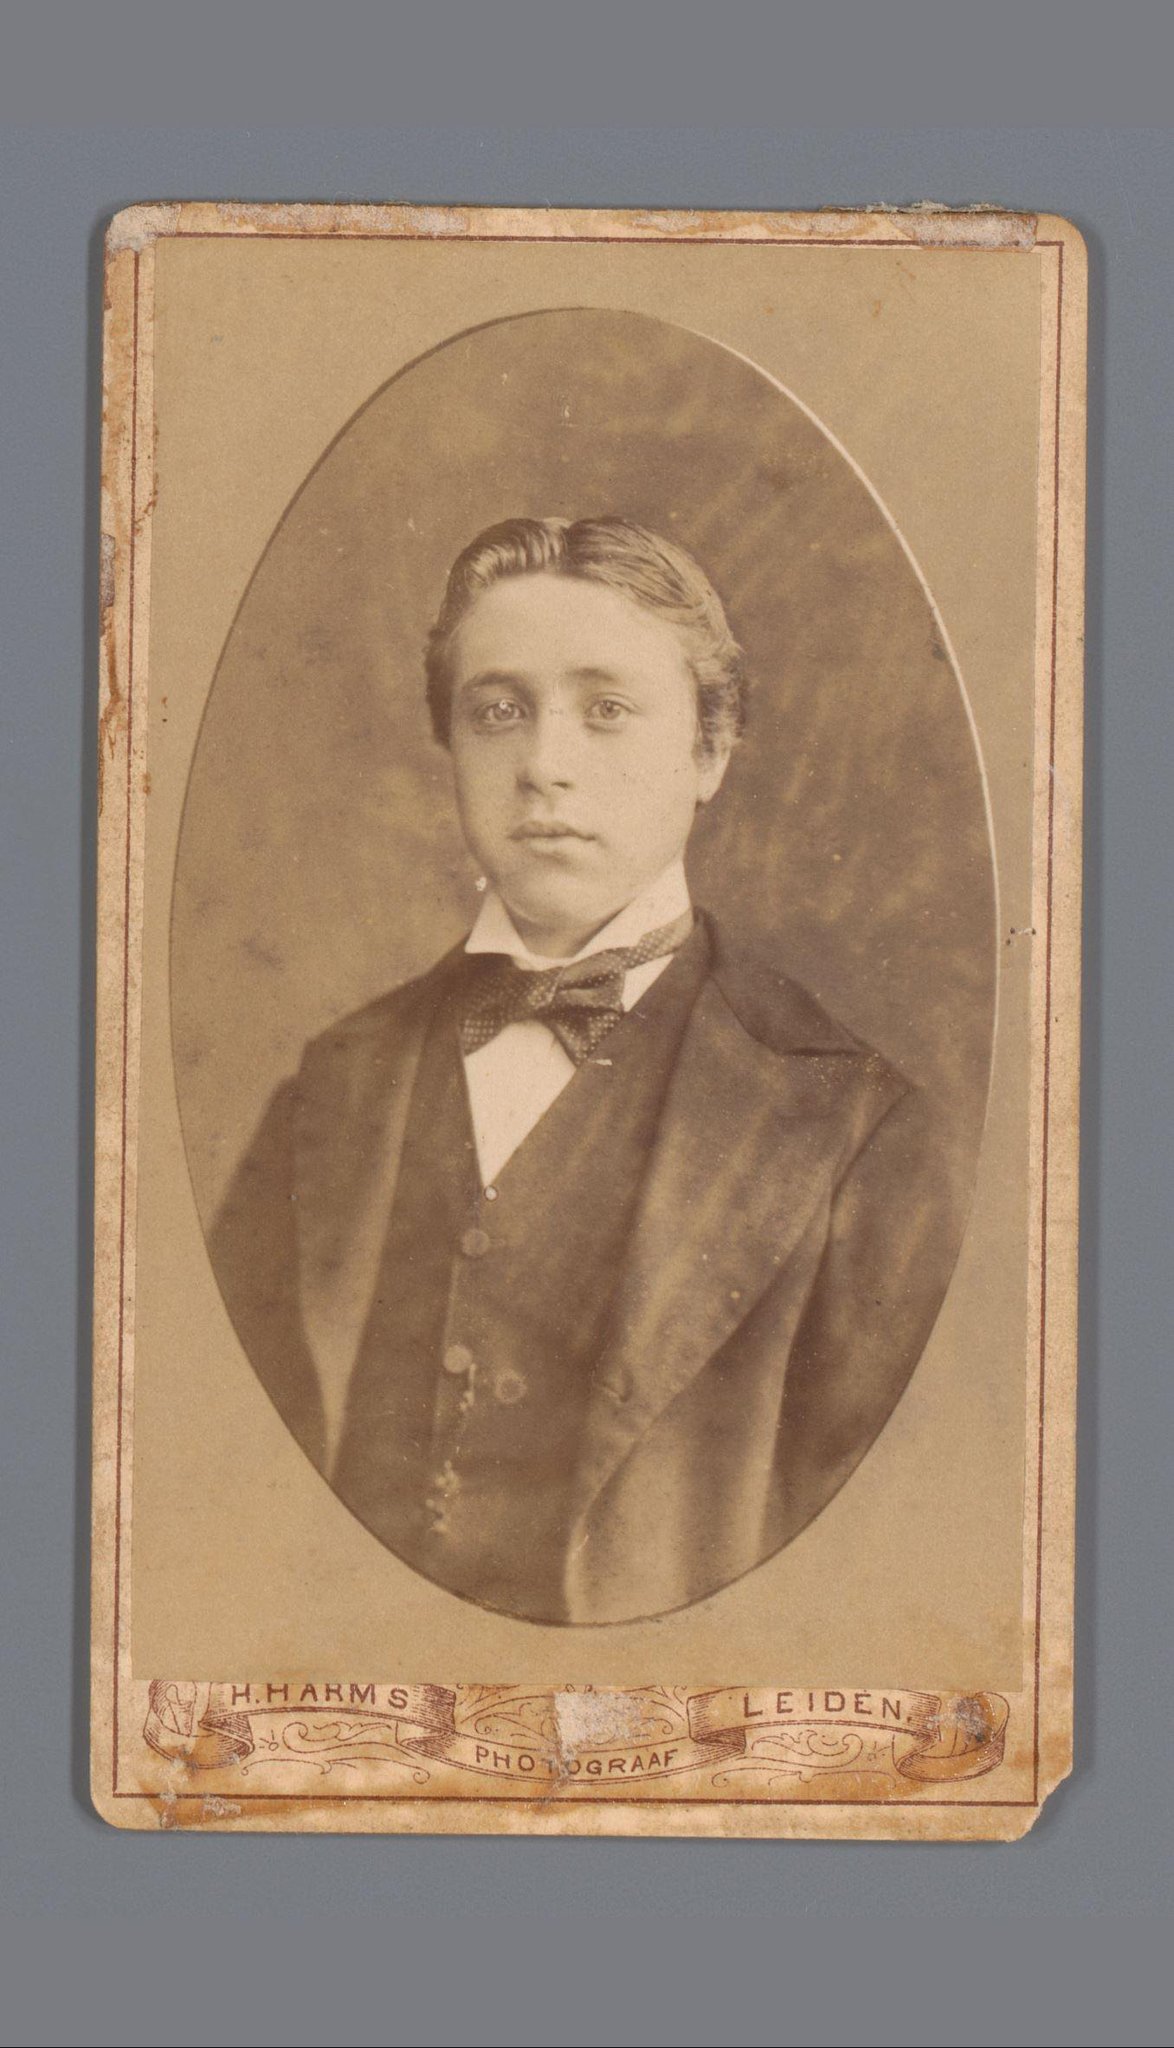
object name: carte de visite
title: Portret van een onbekende man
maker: august ferdinand heinrich harms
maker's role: fotograaf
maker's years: 1845-1916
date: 1871-1882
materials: cardboard, paper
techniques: albumen print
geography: haarlem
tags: adult man, historical persons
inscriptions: inscription: ‘H. HARMS/ Photograaf/ Haverzaklaan/ LEIDEN./ De platen blijven ter nabestelling bewaard.’